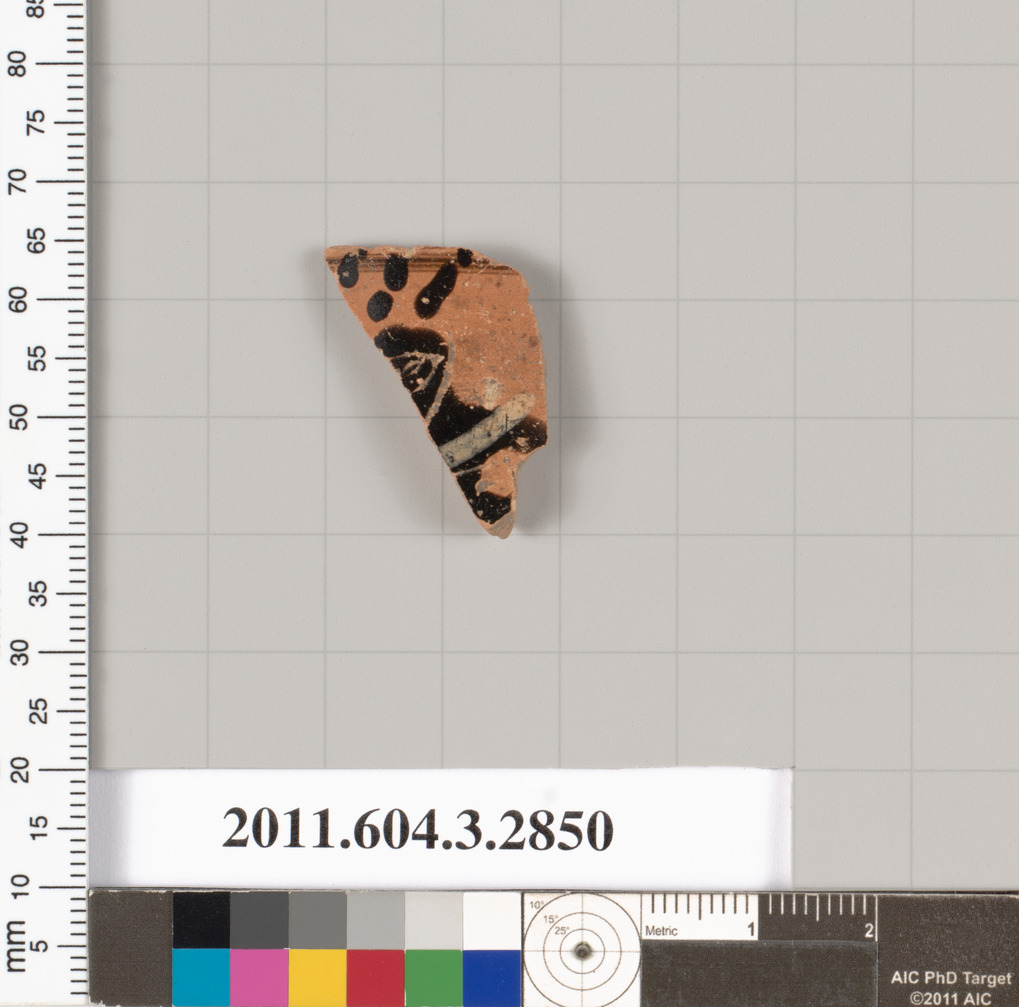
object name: undetermined closed shape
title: Terracotta fragment of a closed shape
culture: greek, attic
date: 534-468 BCE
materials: terracotta